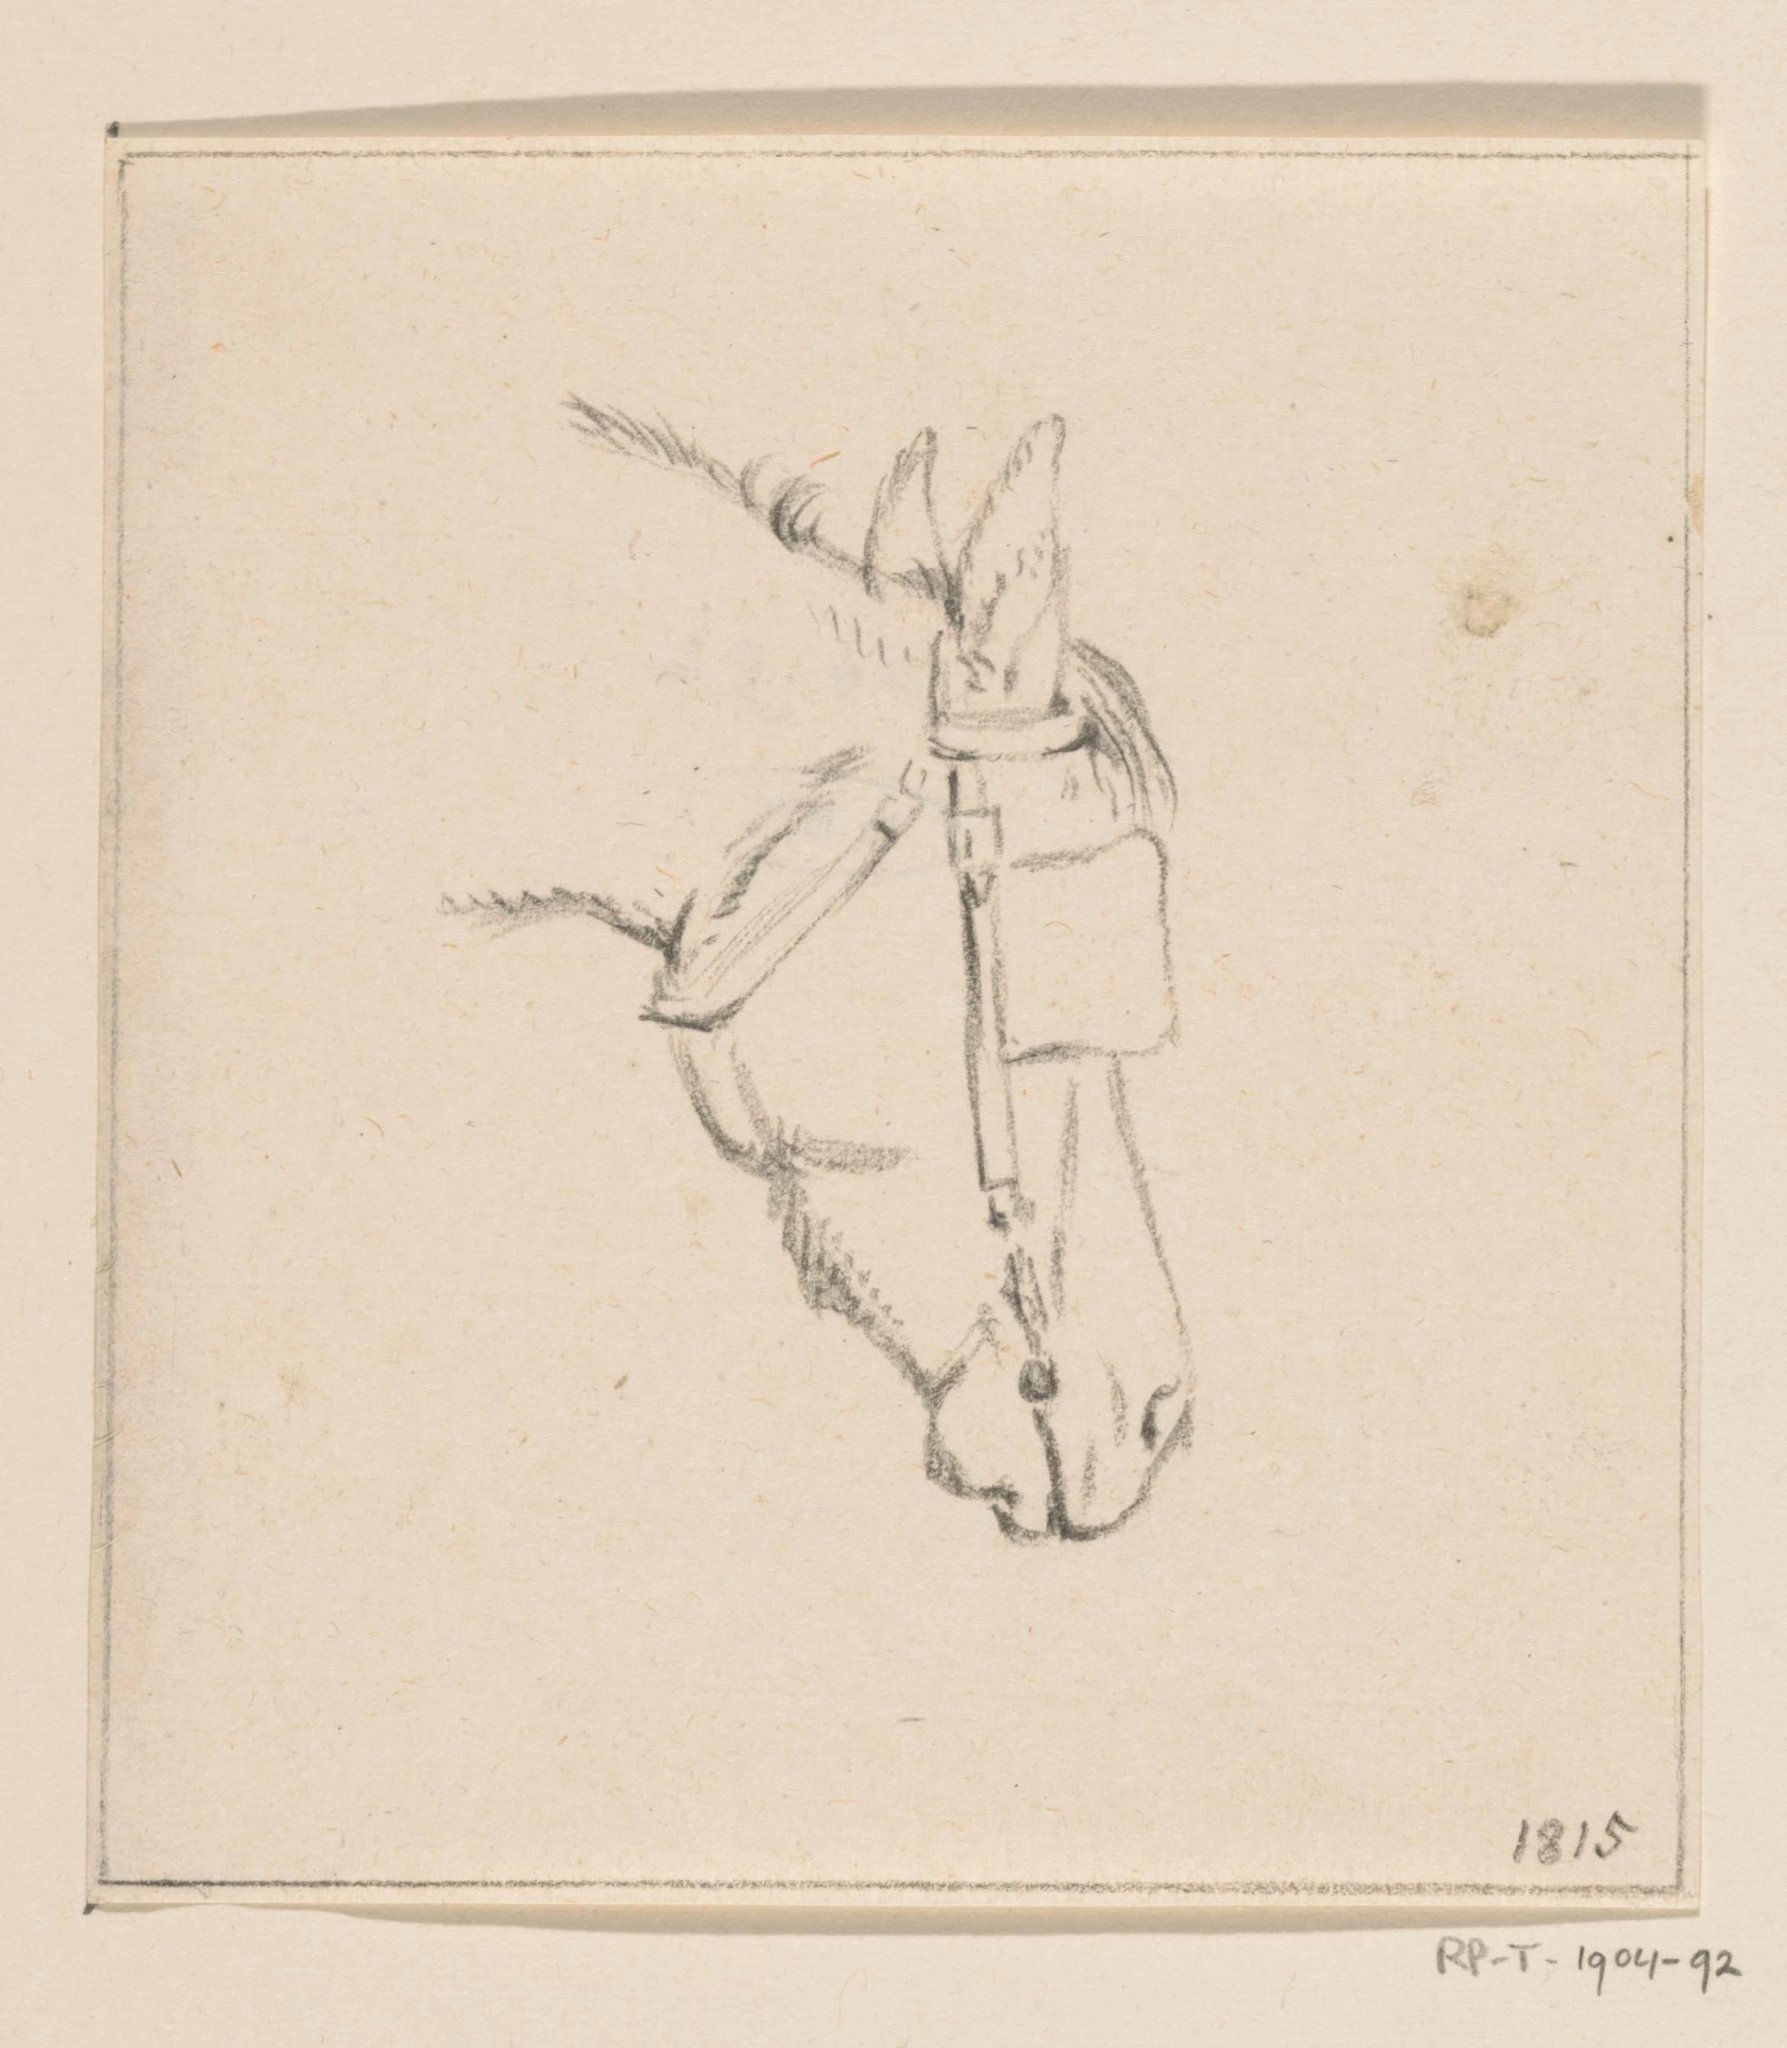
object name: drawing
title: Hoofd van een paard met oogkleppen, naar rechts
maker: jean bernard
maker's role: draughtsman, print maker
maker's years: 1765-1833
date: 1815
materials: chalk, paper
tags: horse